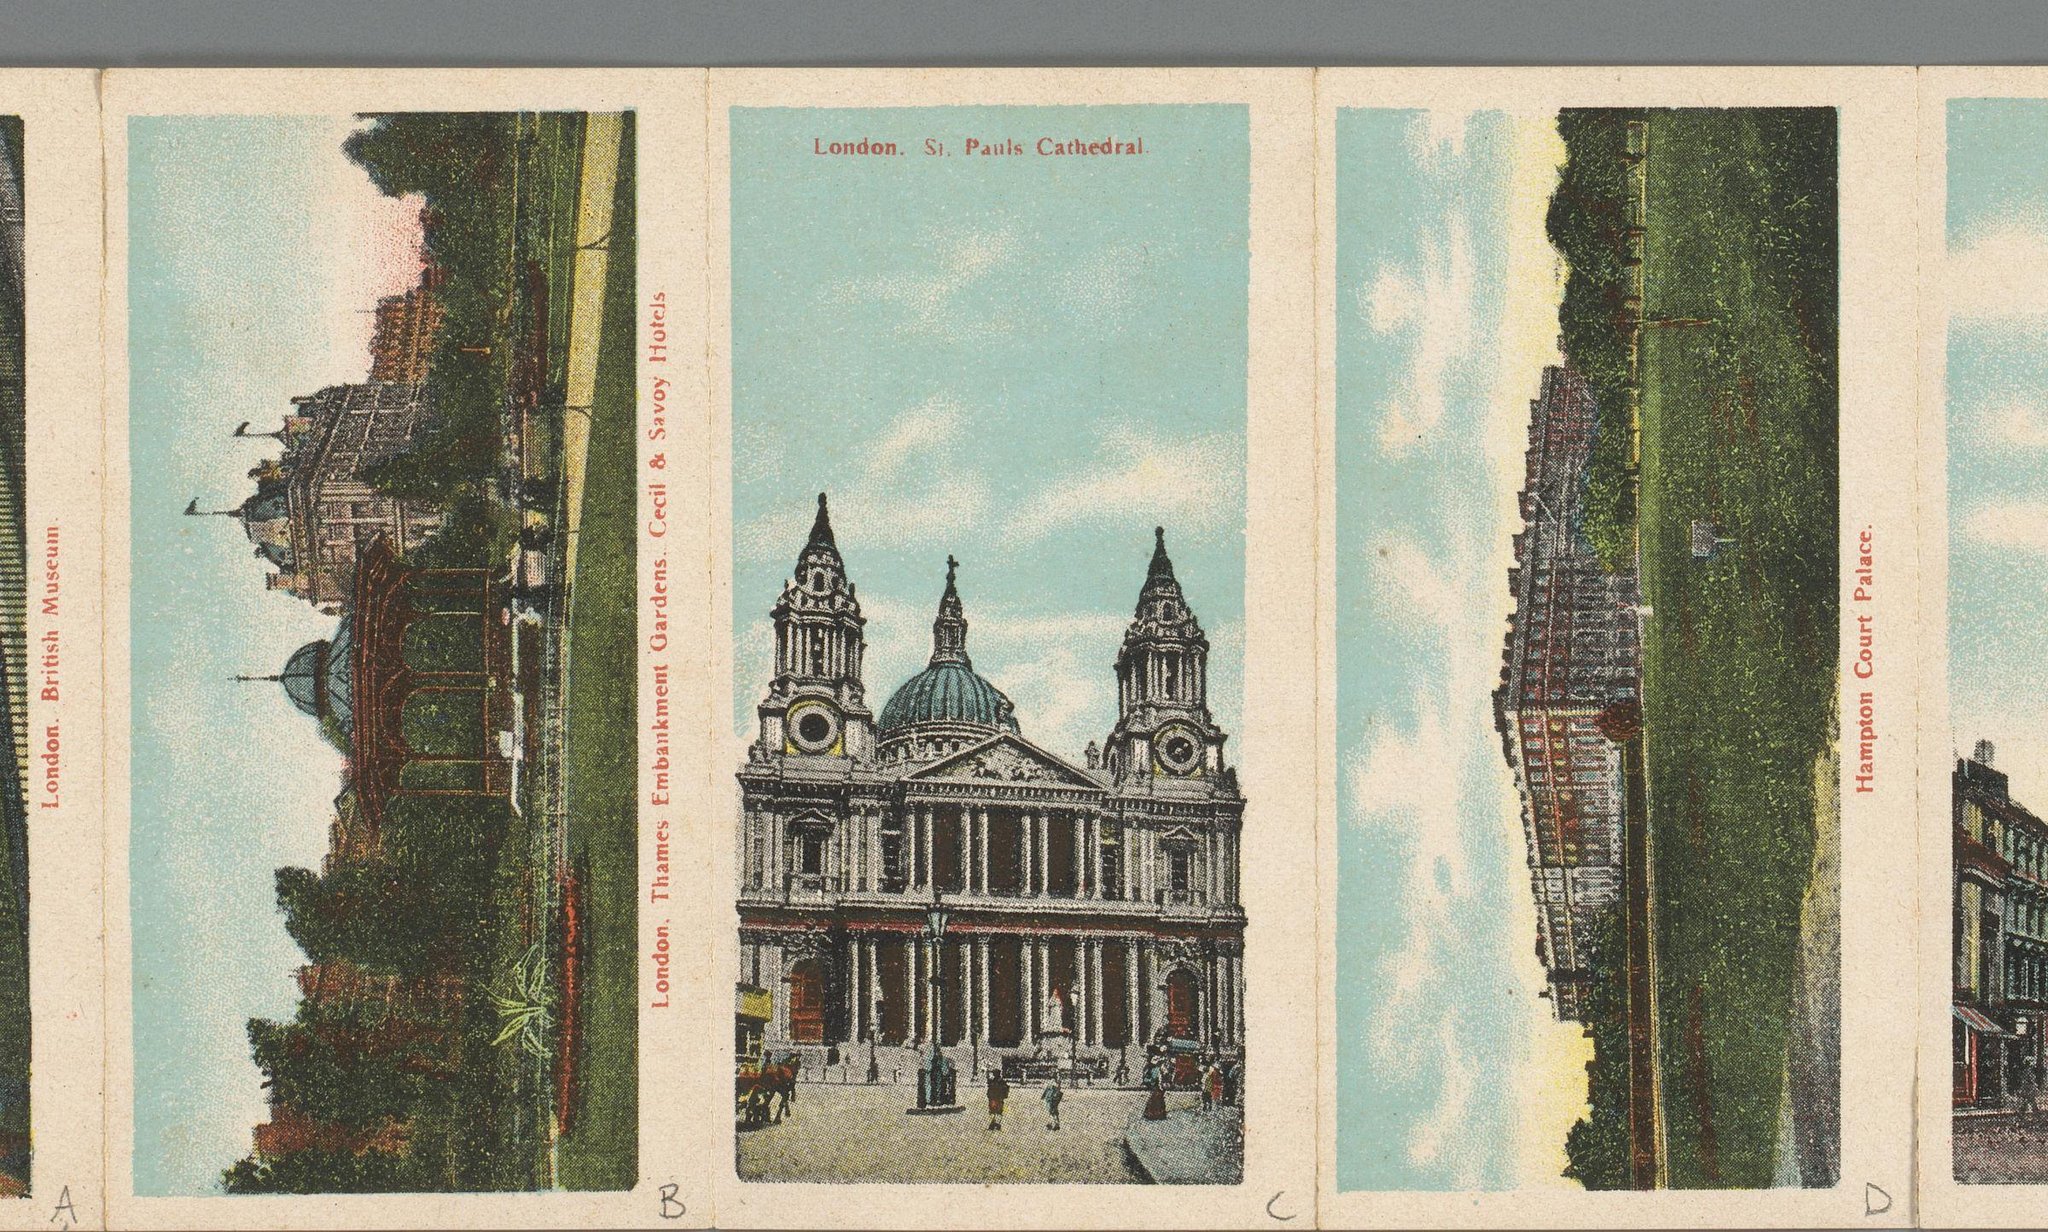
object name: photomechanical print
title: London. St. Pauls Cathedral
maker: Anonymous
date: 1888-1914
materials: paper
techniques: autotype, chromophotolithography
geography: london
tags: parts of church exterior and annexes: façade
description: Deze prent maakt deel uit van een album.